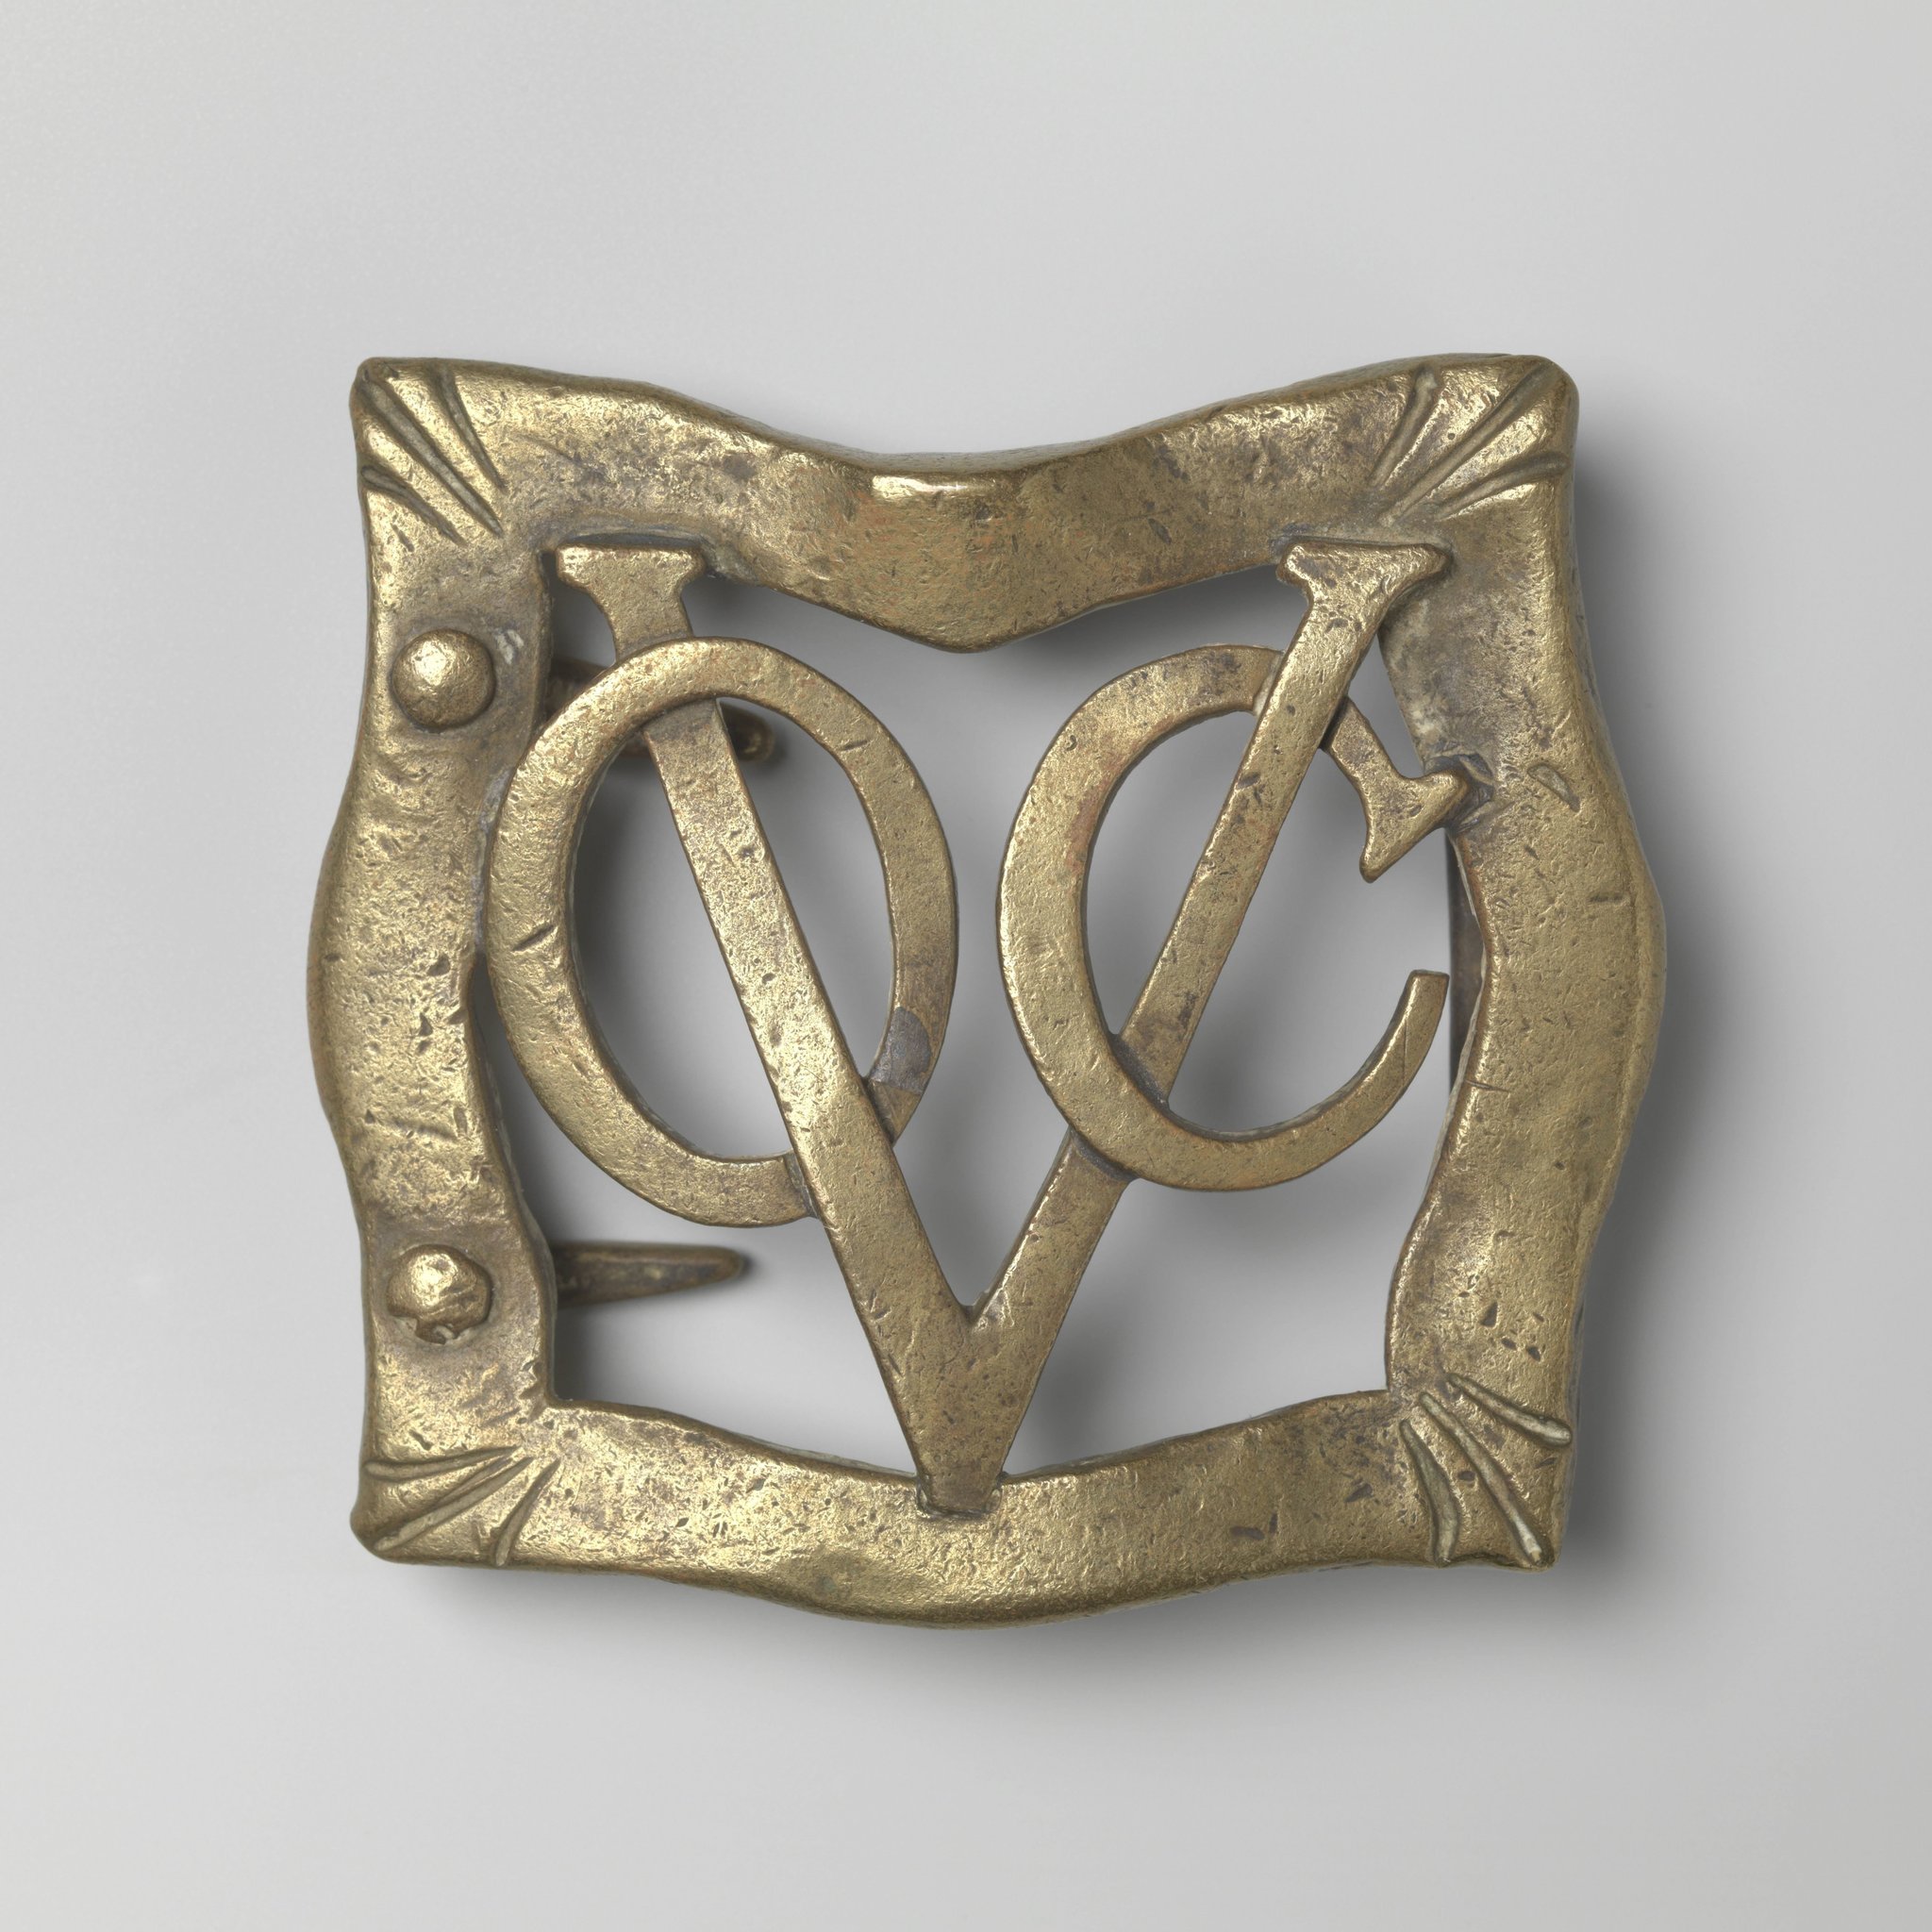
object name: koppelgesp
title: Koppelgesp van V.O.C.-militair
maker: Anonymous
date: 1700-1800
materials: brass, iron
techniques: casting, forging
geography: netherlands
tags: verenigde oostindische compagnie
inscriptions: inscription: ‘V O C’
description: Gesp bestaande uit een vierkante beugel met kromming in alle zijden. Op de horizontale zijden van de beugel is het opschrift, in reliëf, bevestigd. Keerzijde: aan linkerkant twee haken, en aan rechterizijde een spijl.